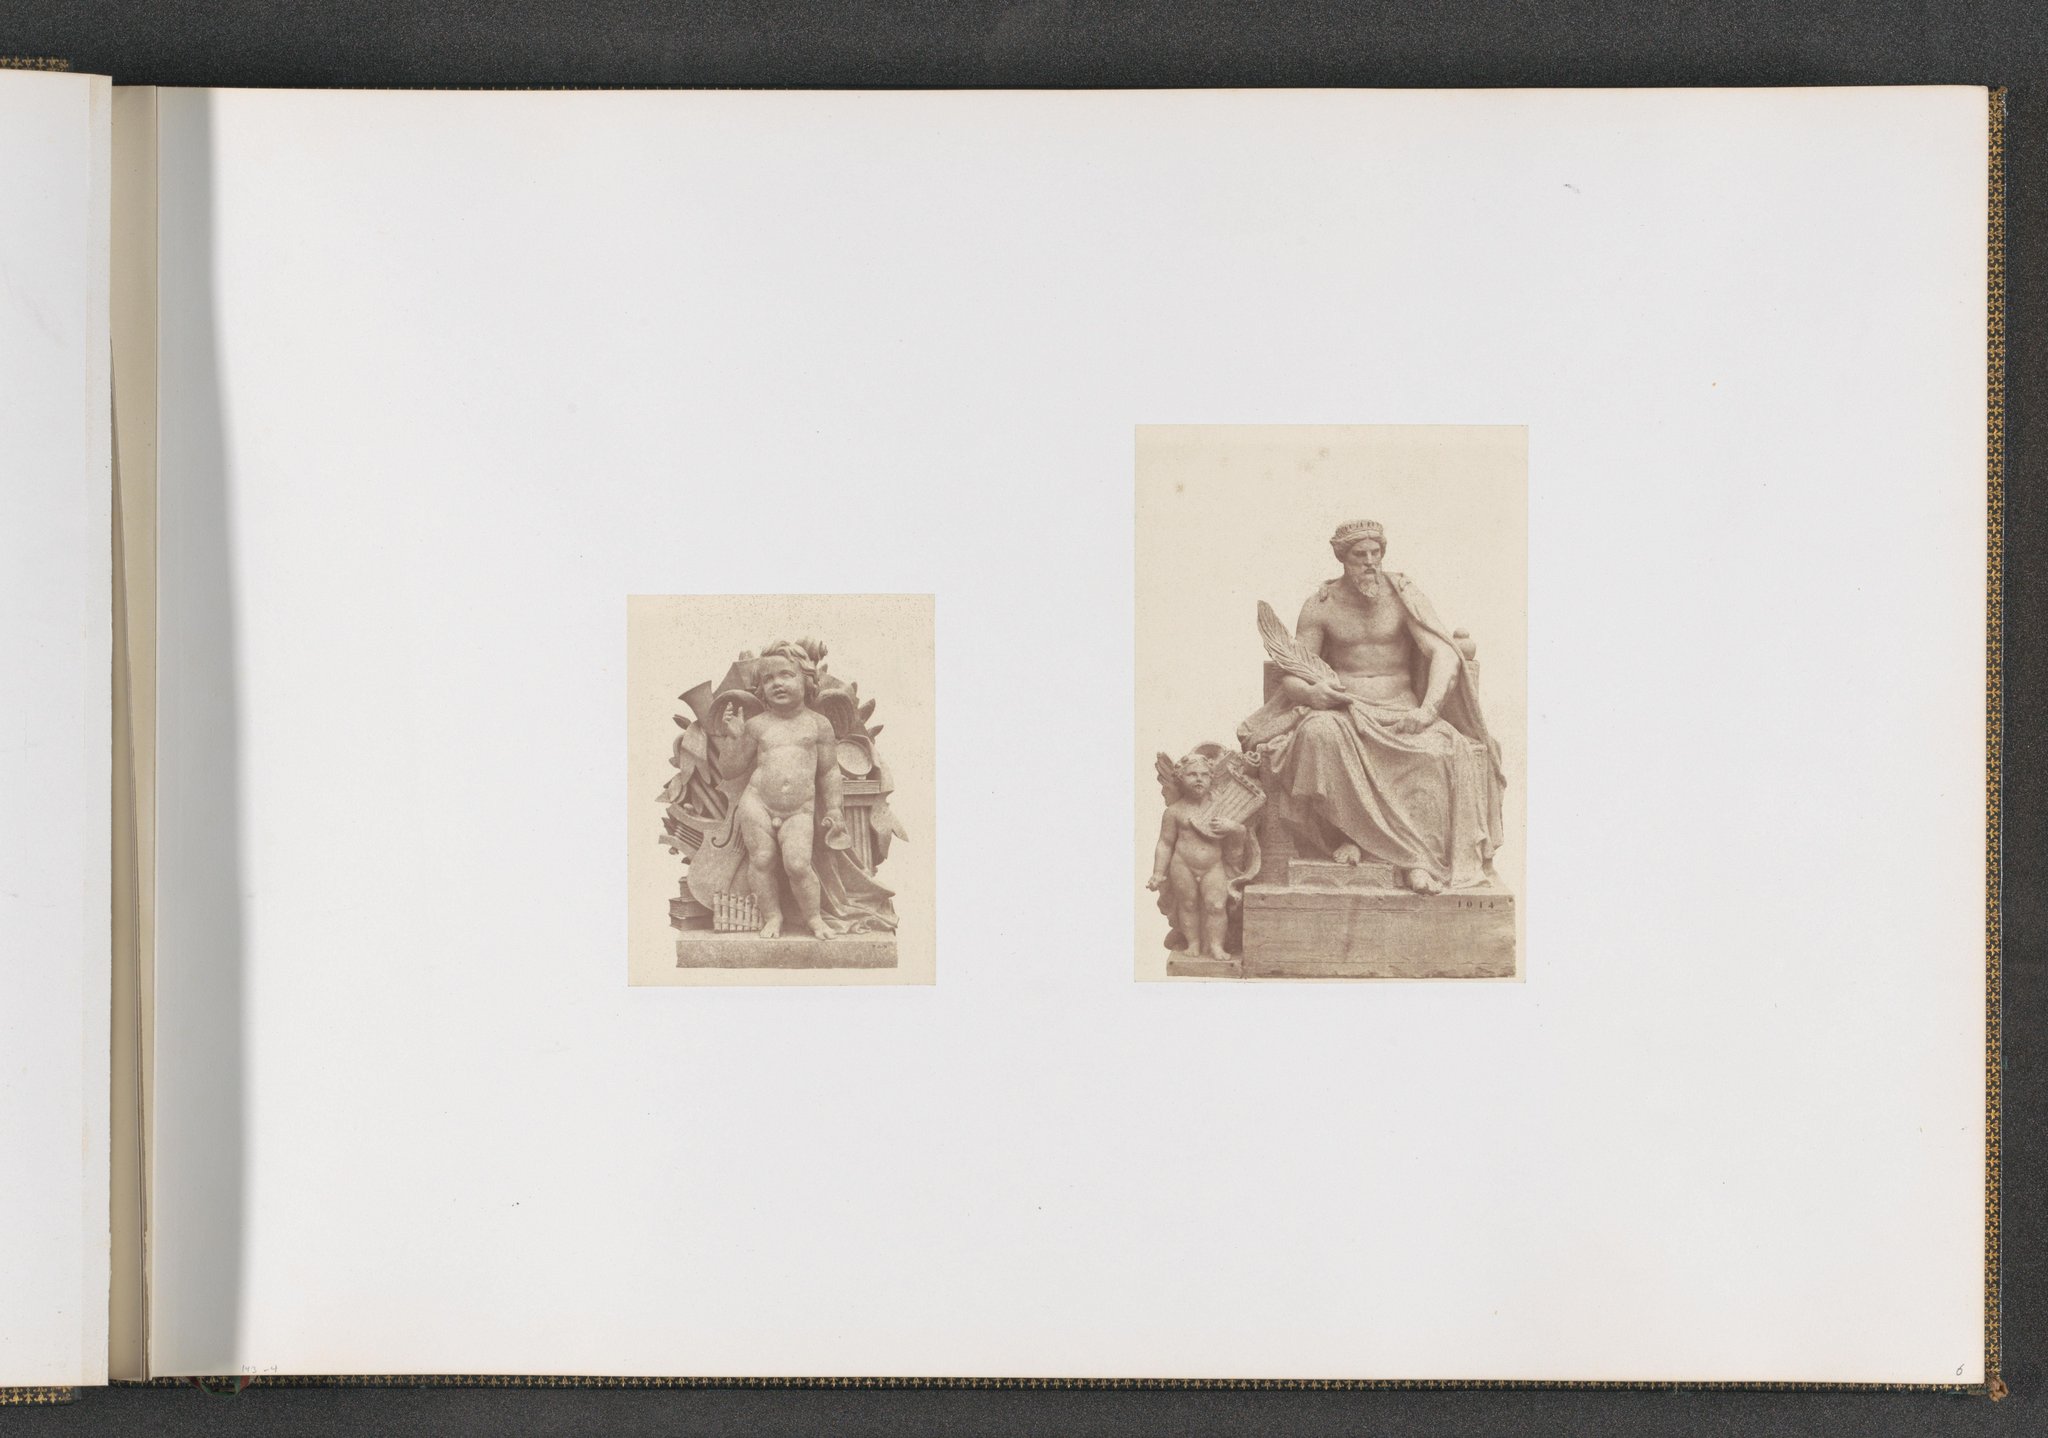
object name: album leaf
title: Gipsmodellen voor beeldhouwwerken op het Palais du Louvre: links "La Musique" door Jules Salmson en rechts "L'Art assyrien" door Jean Louis Nicolas Jaley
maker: édouard denis baldus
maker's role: fotograaf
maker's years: 1813-1889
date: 1855-1857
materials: paper, photographic support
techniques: salted paper print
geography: paris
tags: piece of sculpture, reproduction of a piece of sculpture, permanent exhibition, museum, paris, tuileries palace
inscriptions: number: ‘989 en 1014’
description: Onderdeel van Réunion des Tuileries au Louvre 1852-1857, album 2.